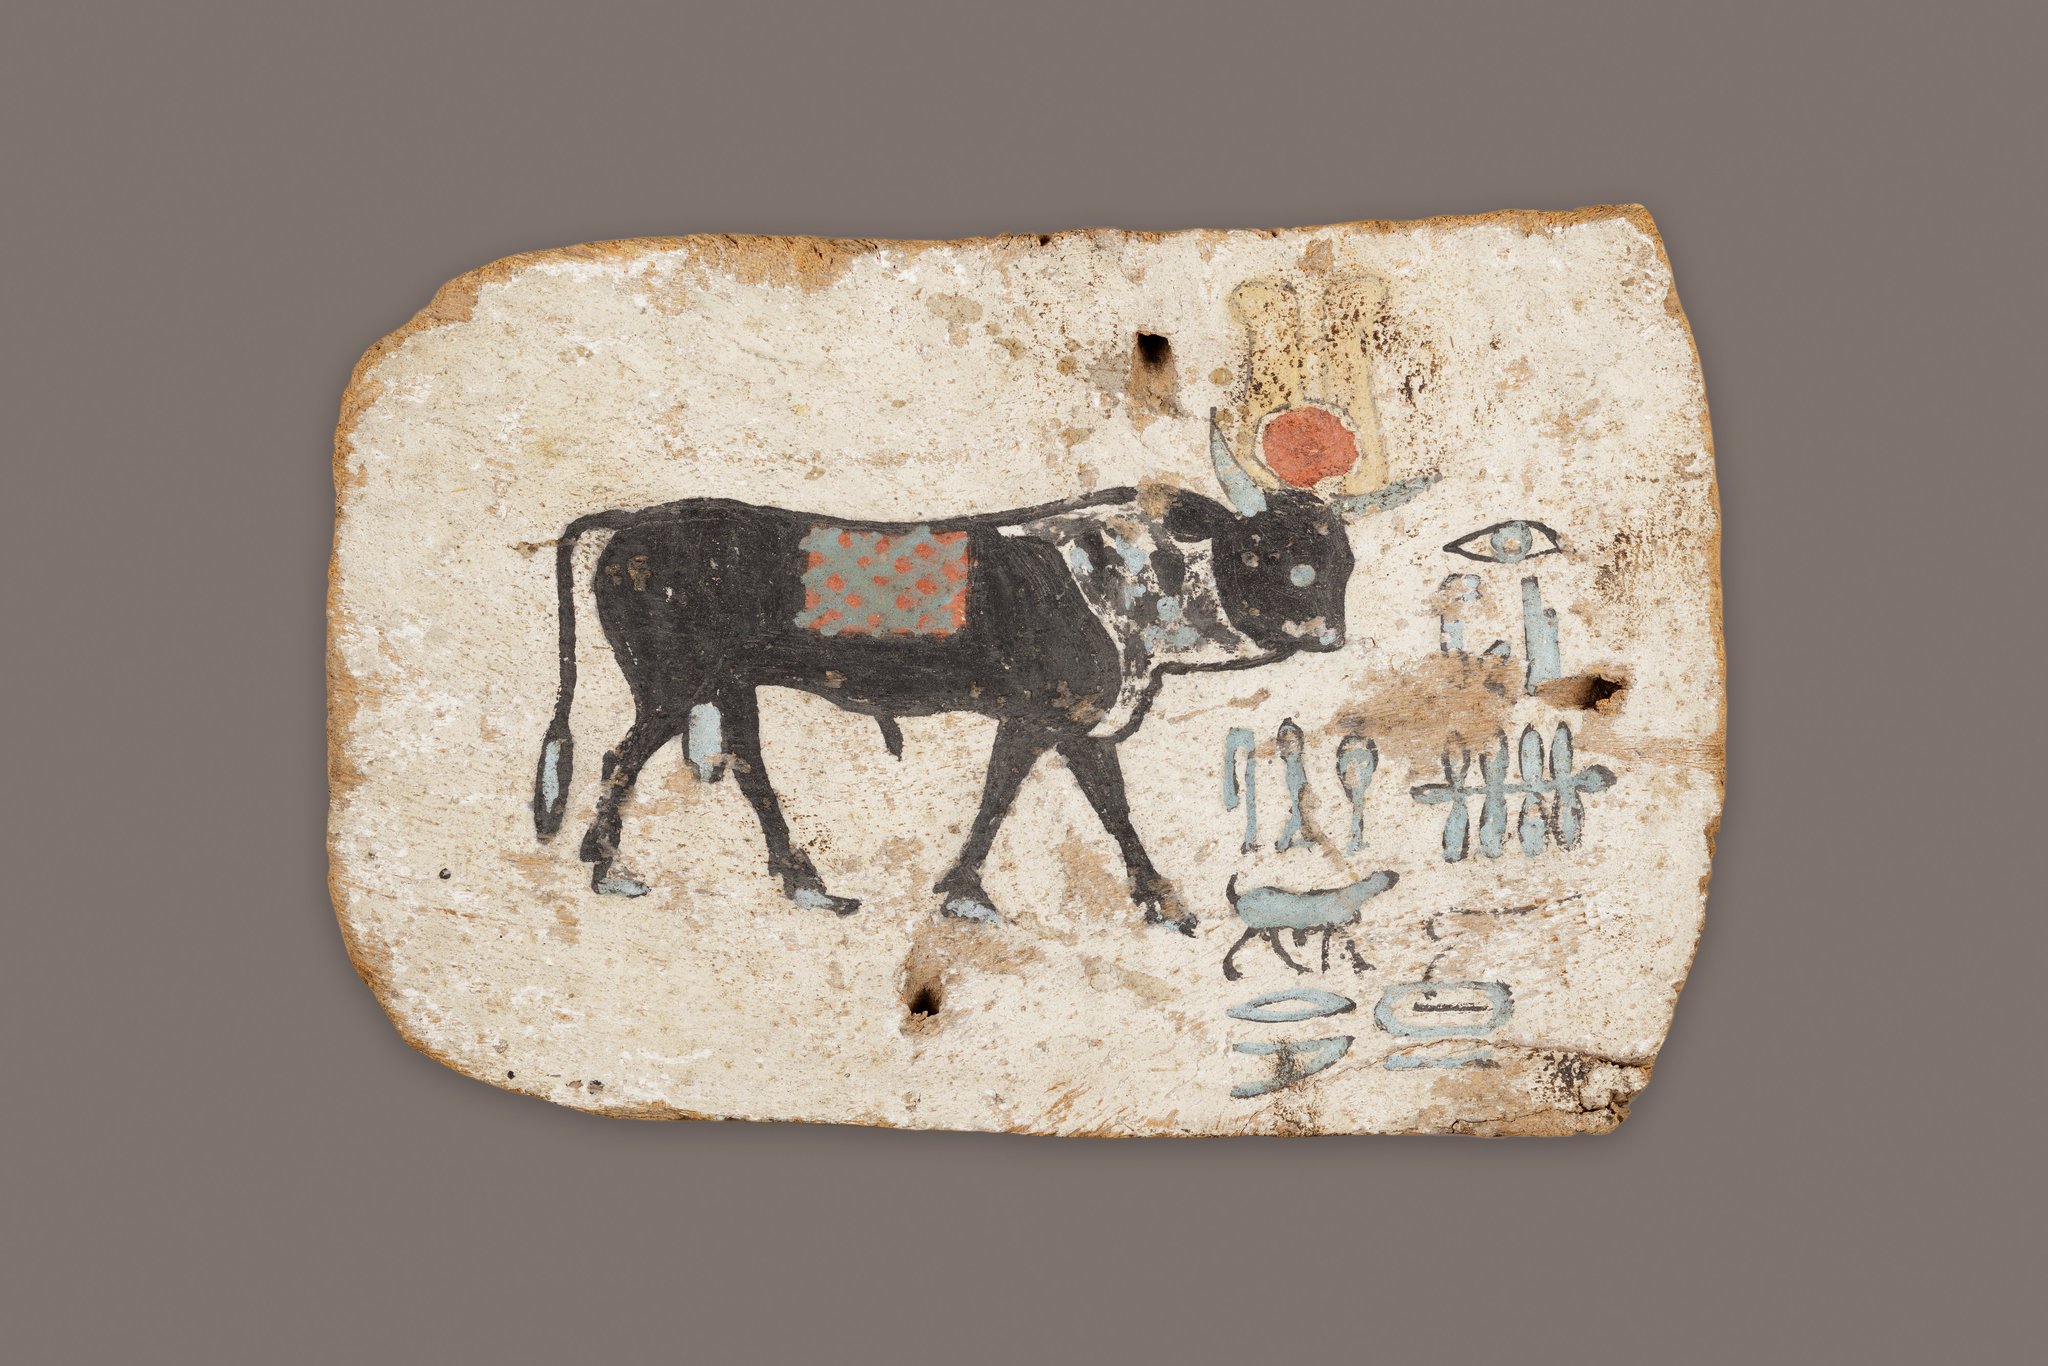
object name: coffin foot painting, apis bull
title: Footboard from a cartonnage coffin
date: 818-332 BCE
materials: paint, wood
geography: egypt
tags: bulls